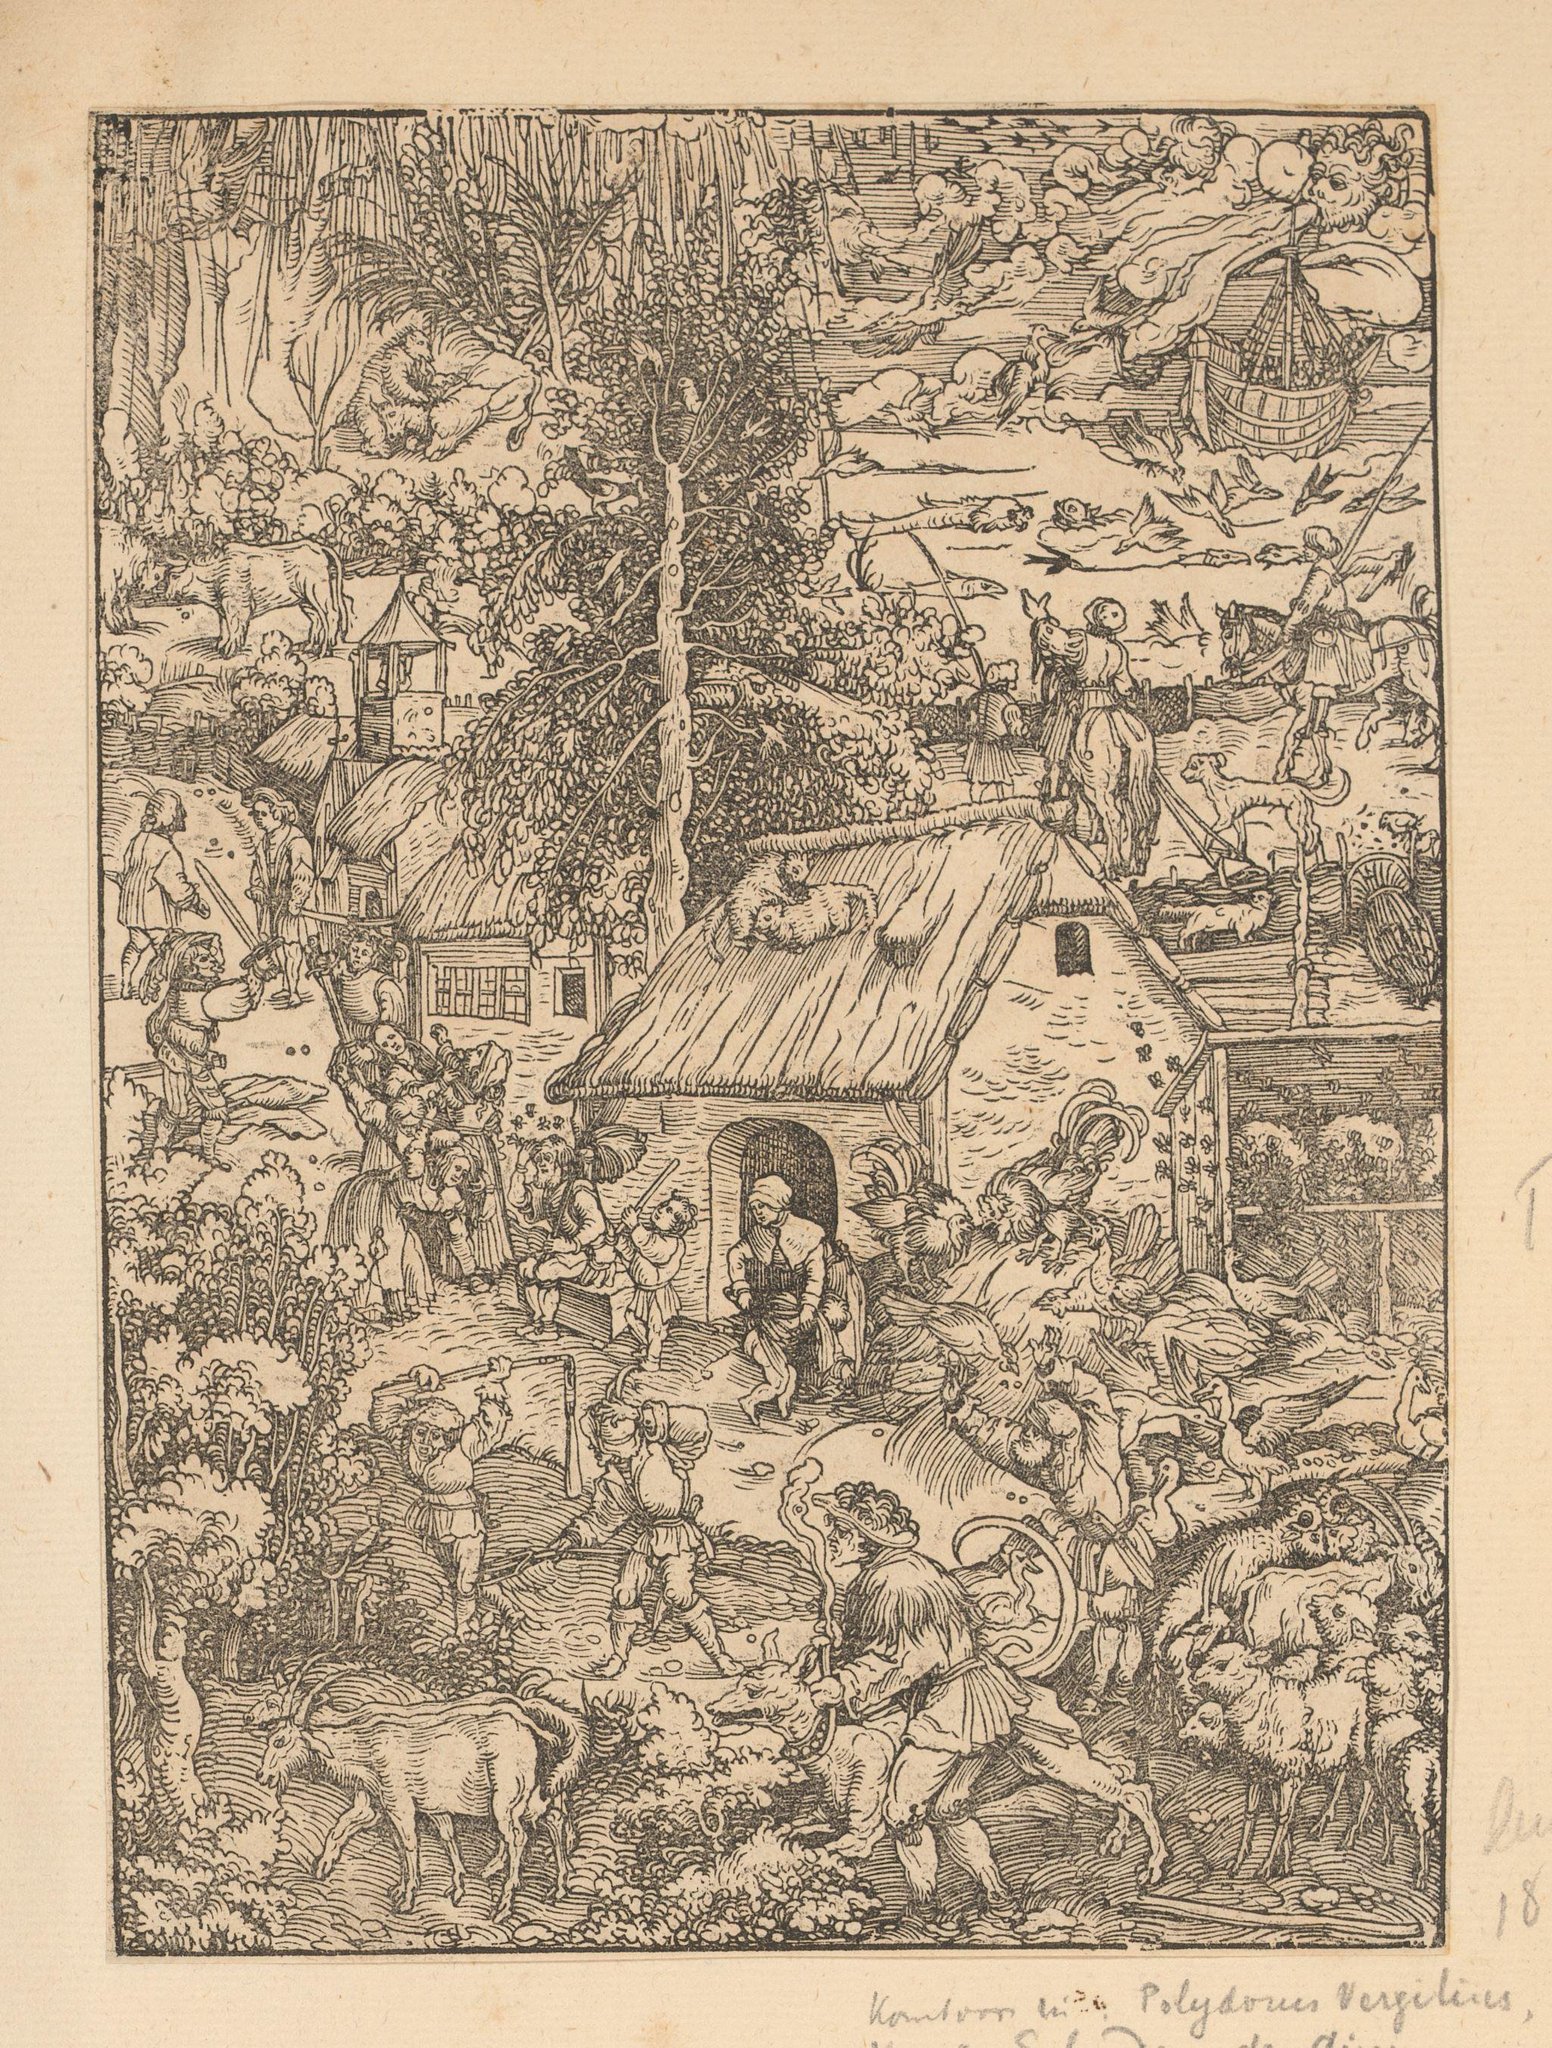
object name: print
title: Mensen- en dierenrijk om een huis heen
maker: Anonymous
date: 1514-1532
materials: paper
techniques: letterpress printing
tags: ideas on the animal kingdom, the vegetable world, realia ~ non-christian religions, good and bad weather, man and animal, cottage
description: Deze prent is gebruikt in: Petrarca, Francesco. Von der Artzney bayder Glück, des guten und widerwertigen: unnd weß sich ain yeder inn Gelück und Unglück halten sol (...). Augsburg: Heinrich Steiner, 1532. Deze uitgave is ook bekend onder de titel 'Trostspiegel in Glück und Unglück'. Deze prent is ook gebruikt voor: Urban, Vergilius Polydorus von. Von den Erfindern der Ding (...). [Vertaald uit het Latijn door] Marcus Tatius Alpinus. Augsburg: Heinrich Steiner, 1537.